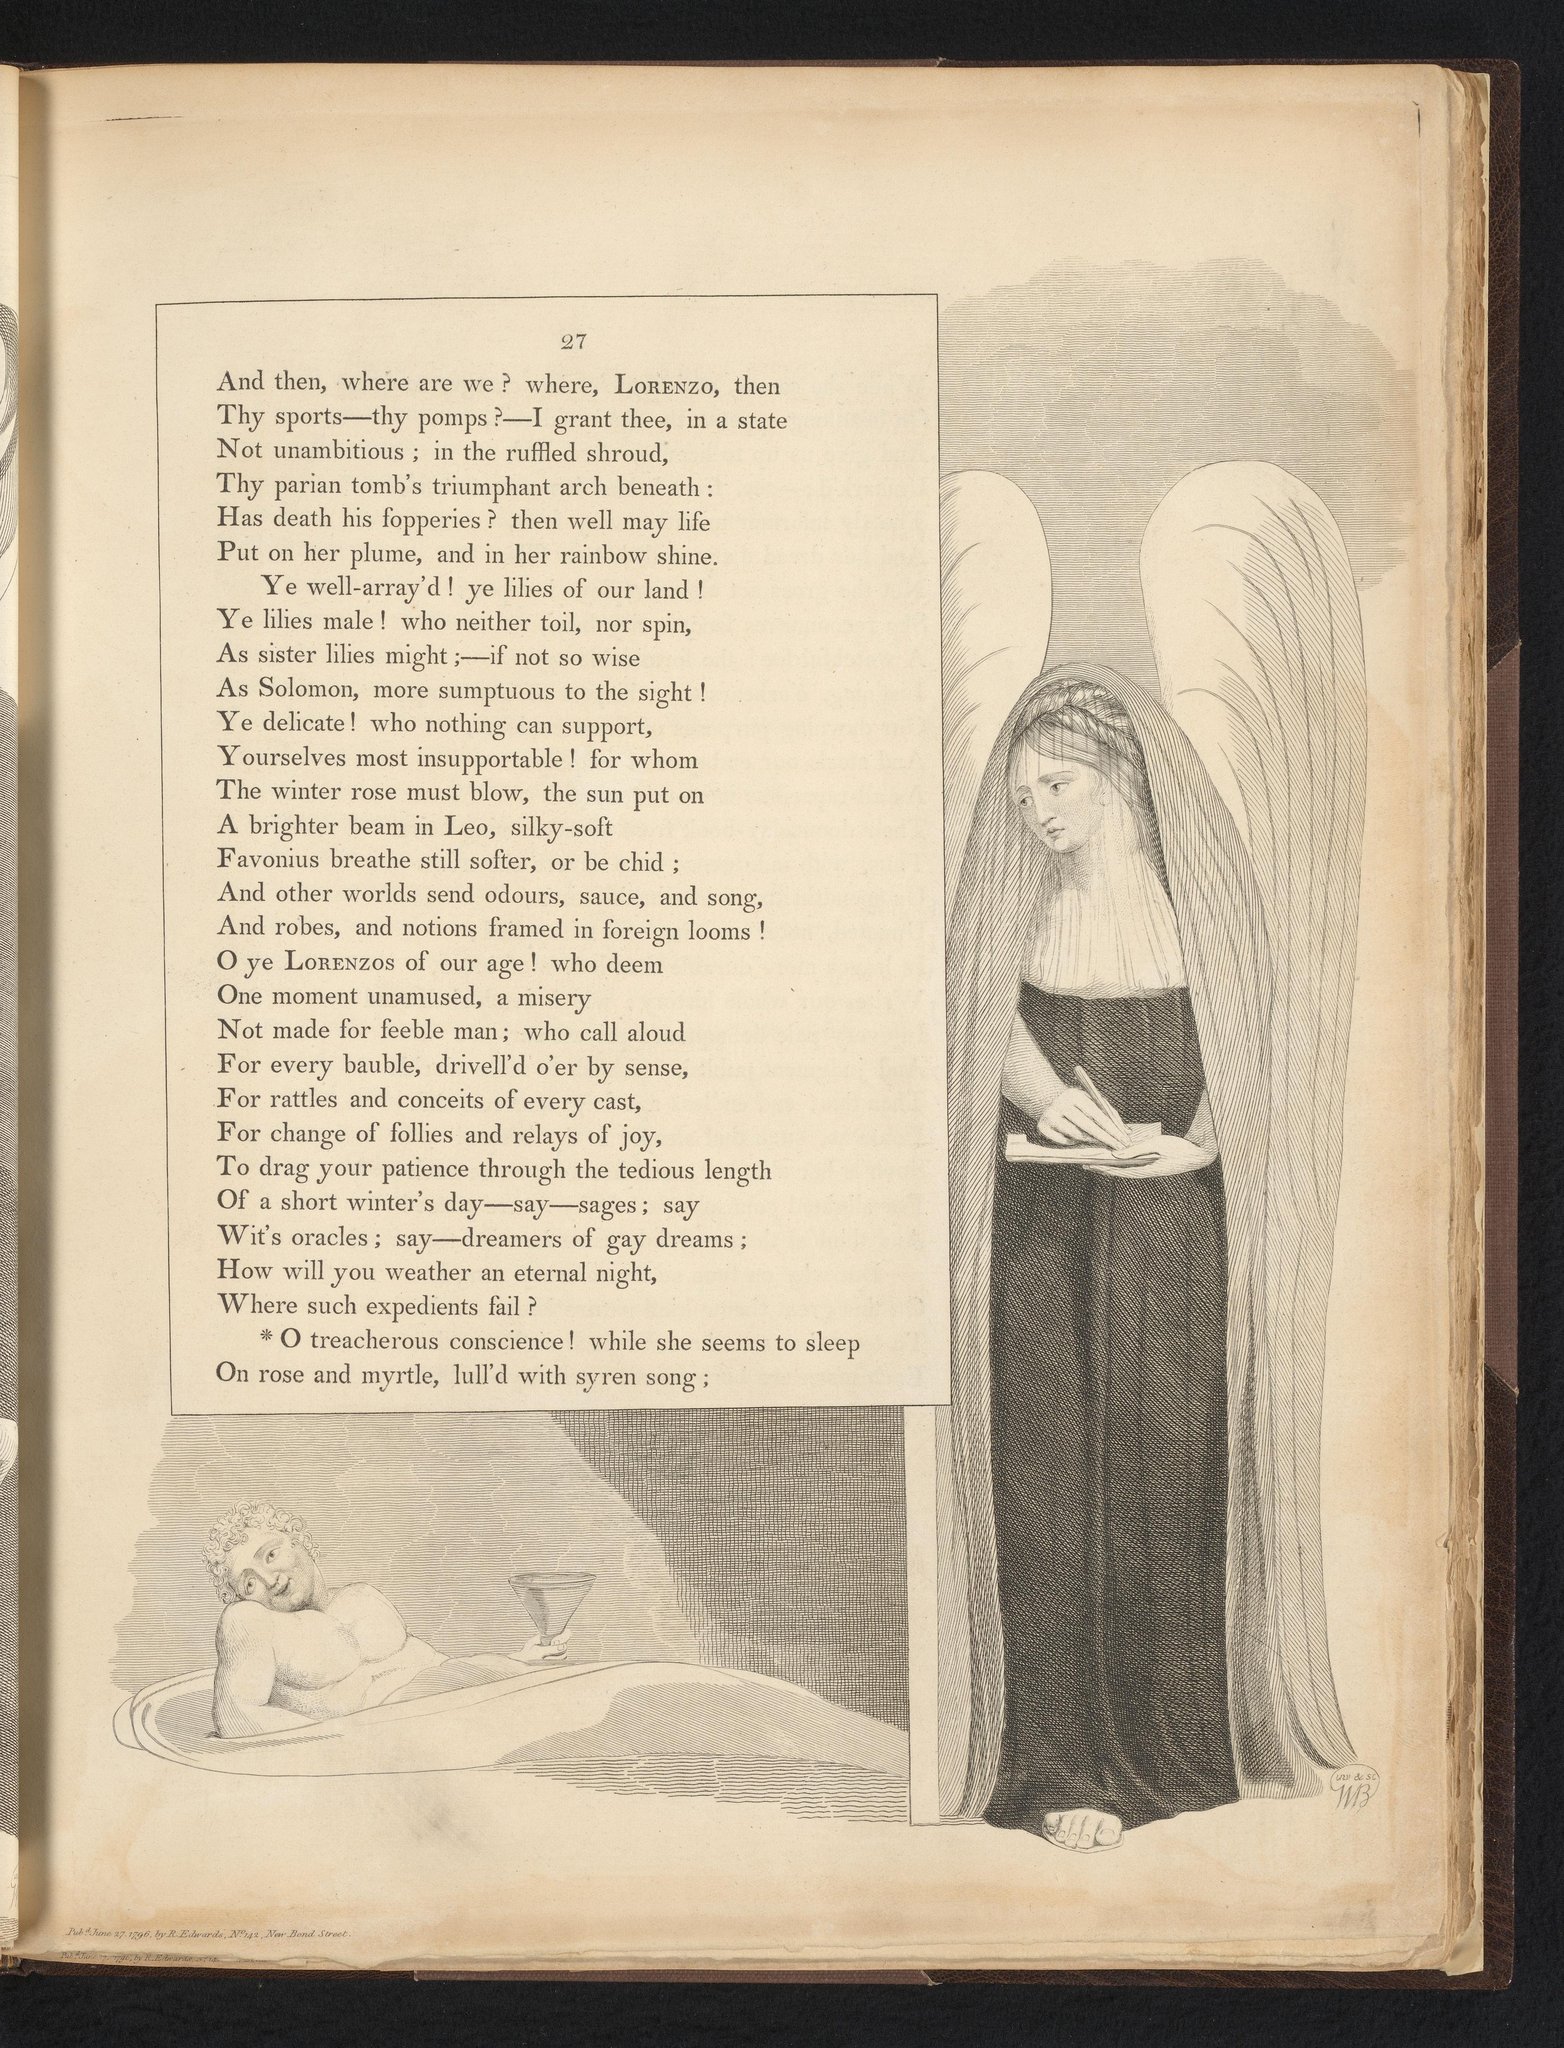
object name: page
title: Schrijvende vrouw met sluier en vleugels en liggende man met beker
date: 1796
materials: paper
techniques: engraving, letterpress printing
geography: london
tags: adult woman, adult man, mourning dress, drinking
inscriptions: : ‘And then, where are we ? where, Lorenzo, then (...)’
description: Prent maakt deel uit van een boek, bladzijde 27. Tekst in het Engels op recto en verso.